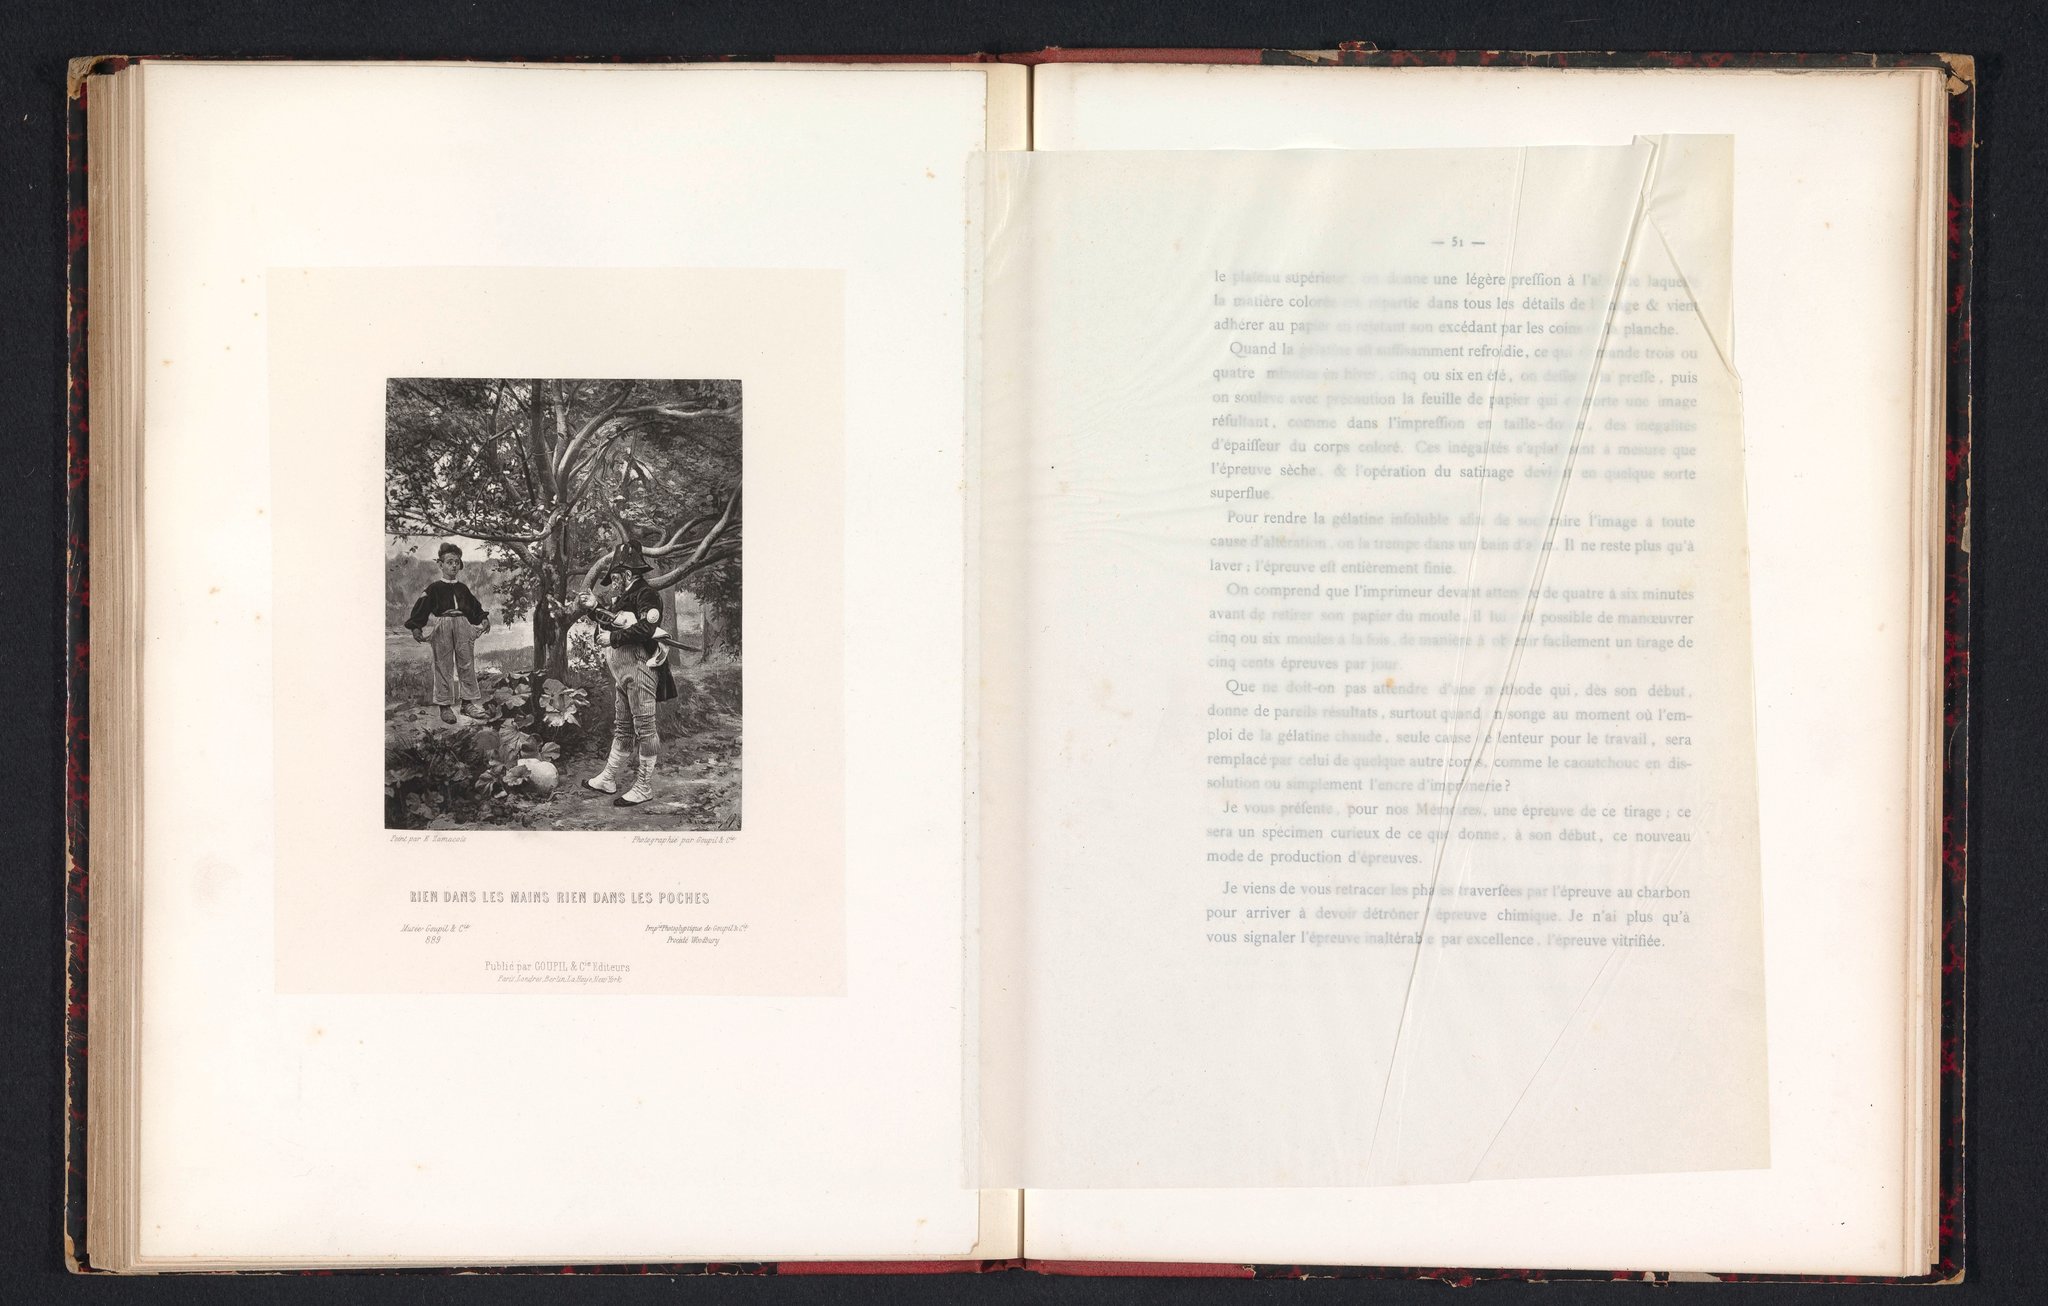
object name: photomechanical print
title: Rien dans les mains rien dans les poches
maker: e. zamacoïs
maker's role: painter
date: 1859-1869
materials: paper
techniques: woodburytype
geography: france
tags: trees, adult man